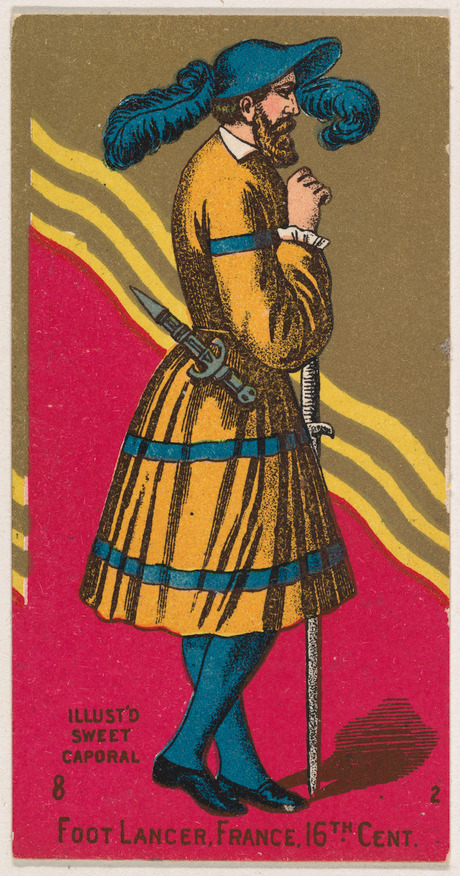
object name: print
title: Foot Lancer, France, 16th Century, from the Military Series (N224) issued by Kinney Tobacco Company to promote Sweet Caporal Cigarettes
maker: kinney brothers tobacco company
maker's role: publisher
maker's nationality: american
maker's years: 1869-2011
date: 1888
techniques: color lithograph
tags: military,daggers,men,profiles